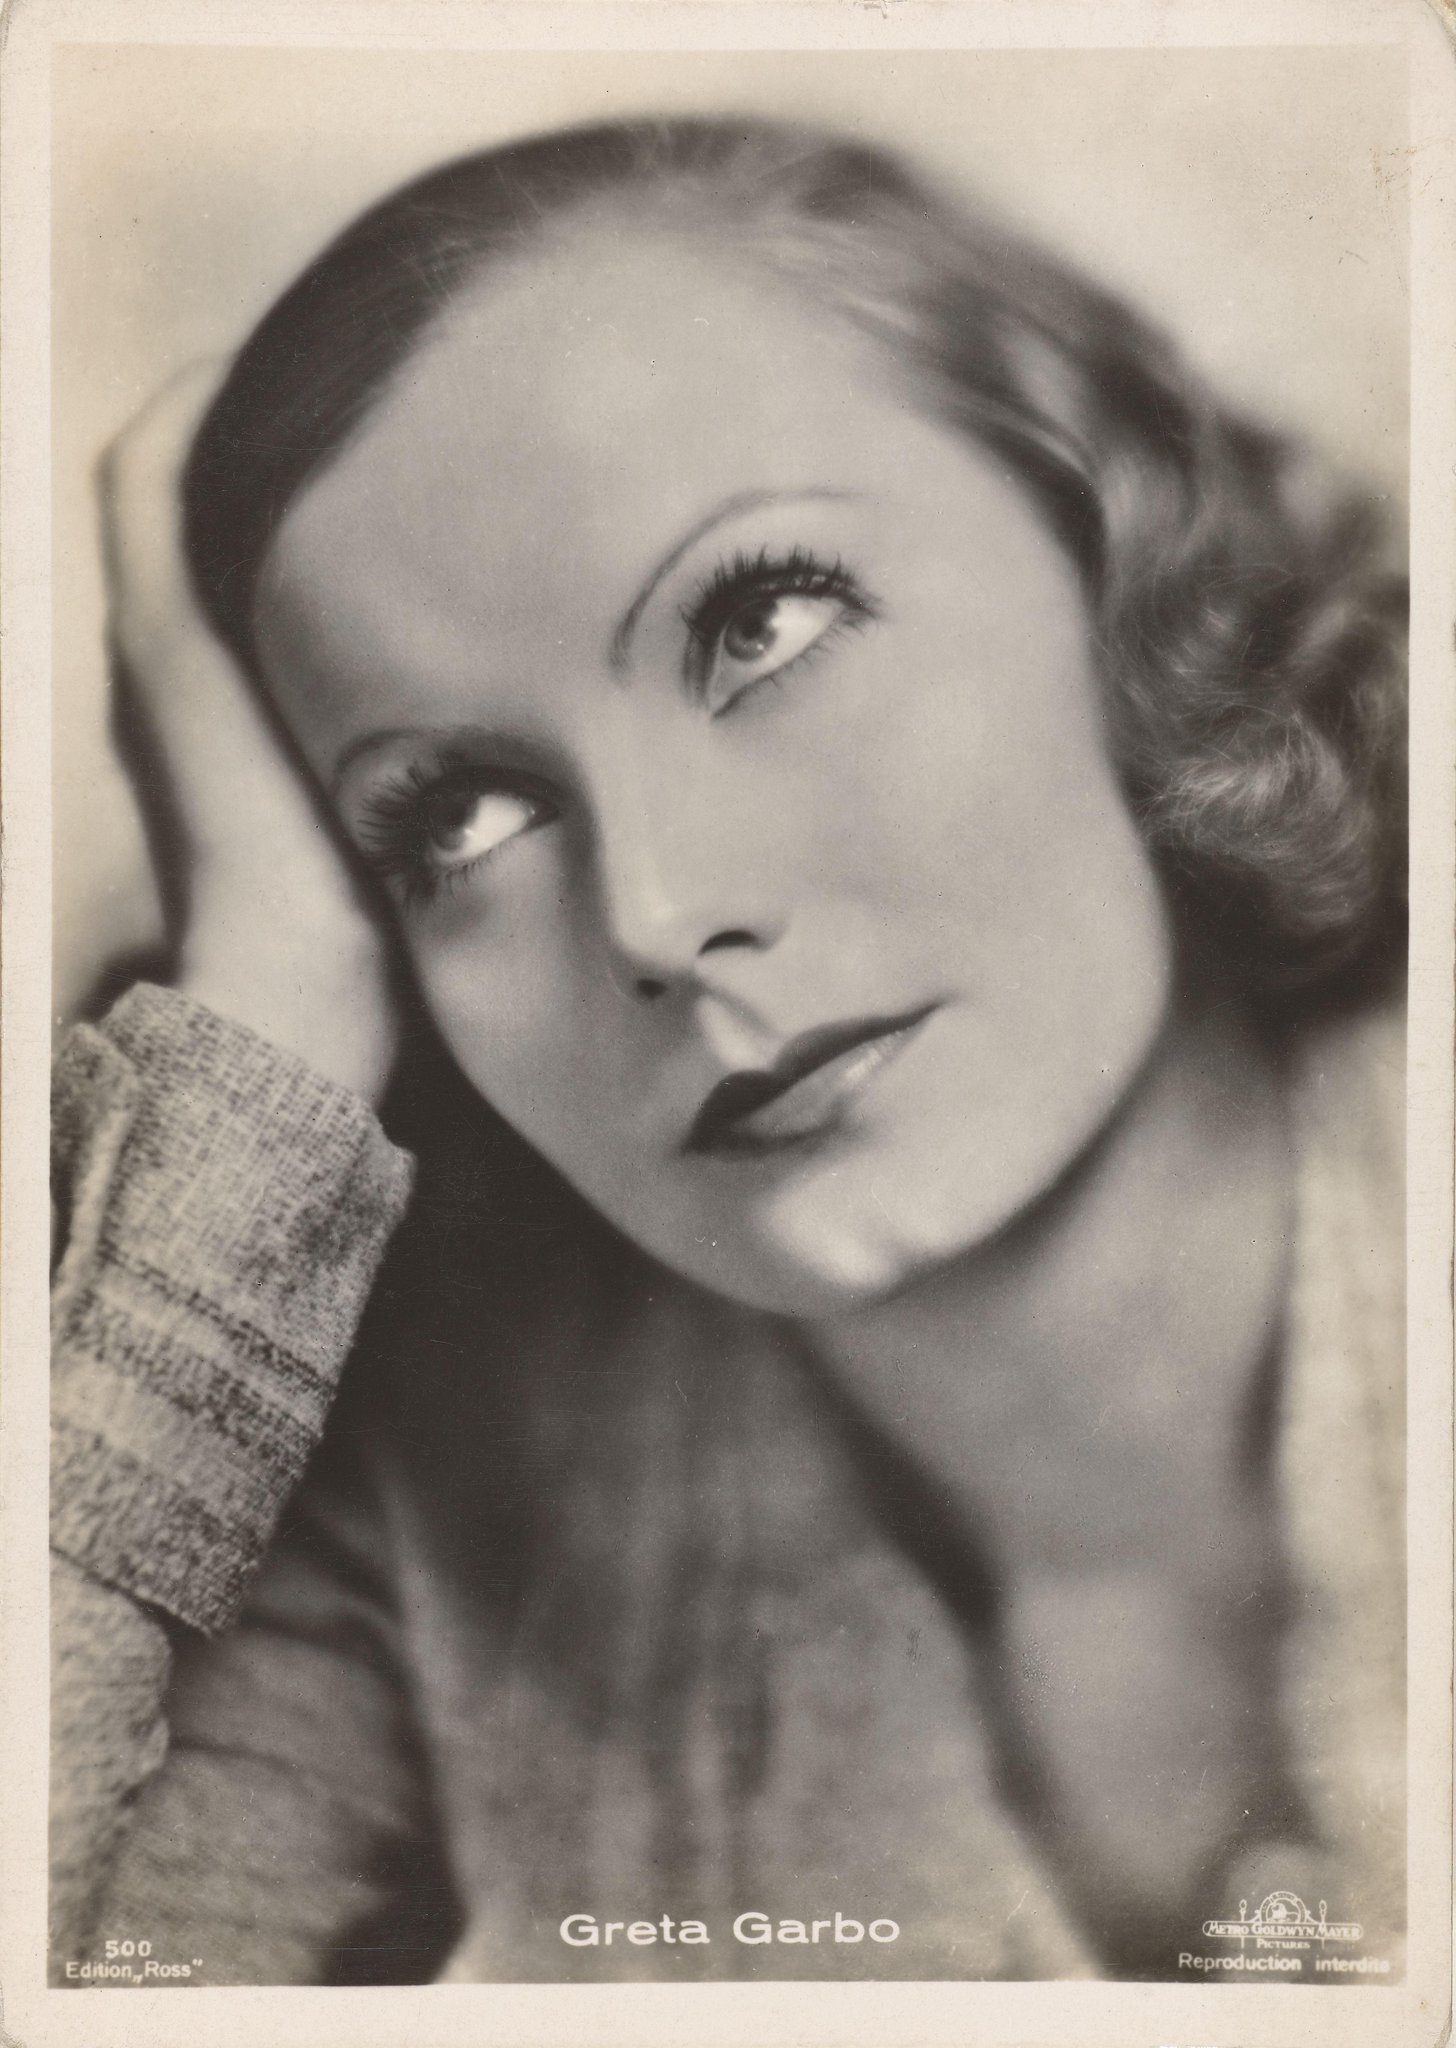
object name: ansichtkaart, prentbriefkaart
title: Greta Garbo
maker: Anonymous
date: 1920-1950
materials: photographic support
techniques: gelatin silver print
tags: new york (city)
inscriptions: annotation: ‘Metro Goldwyn Mayer reproduction interdite / 500 Edison Ross’